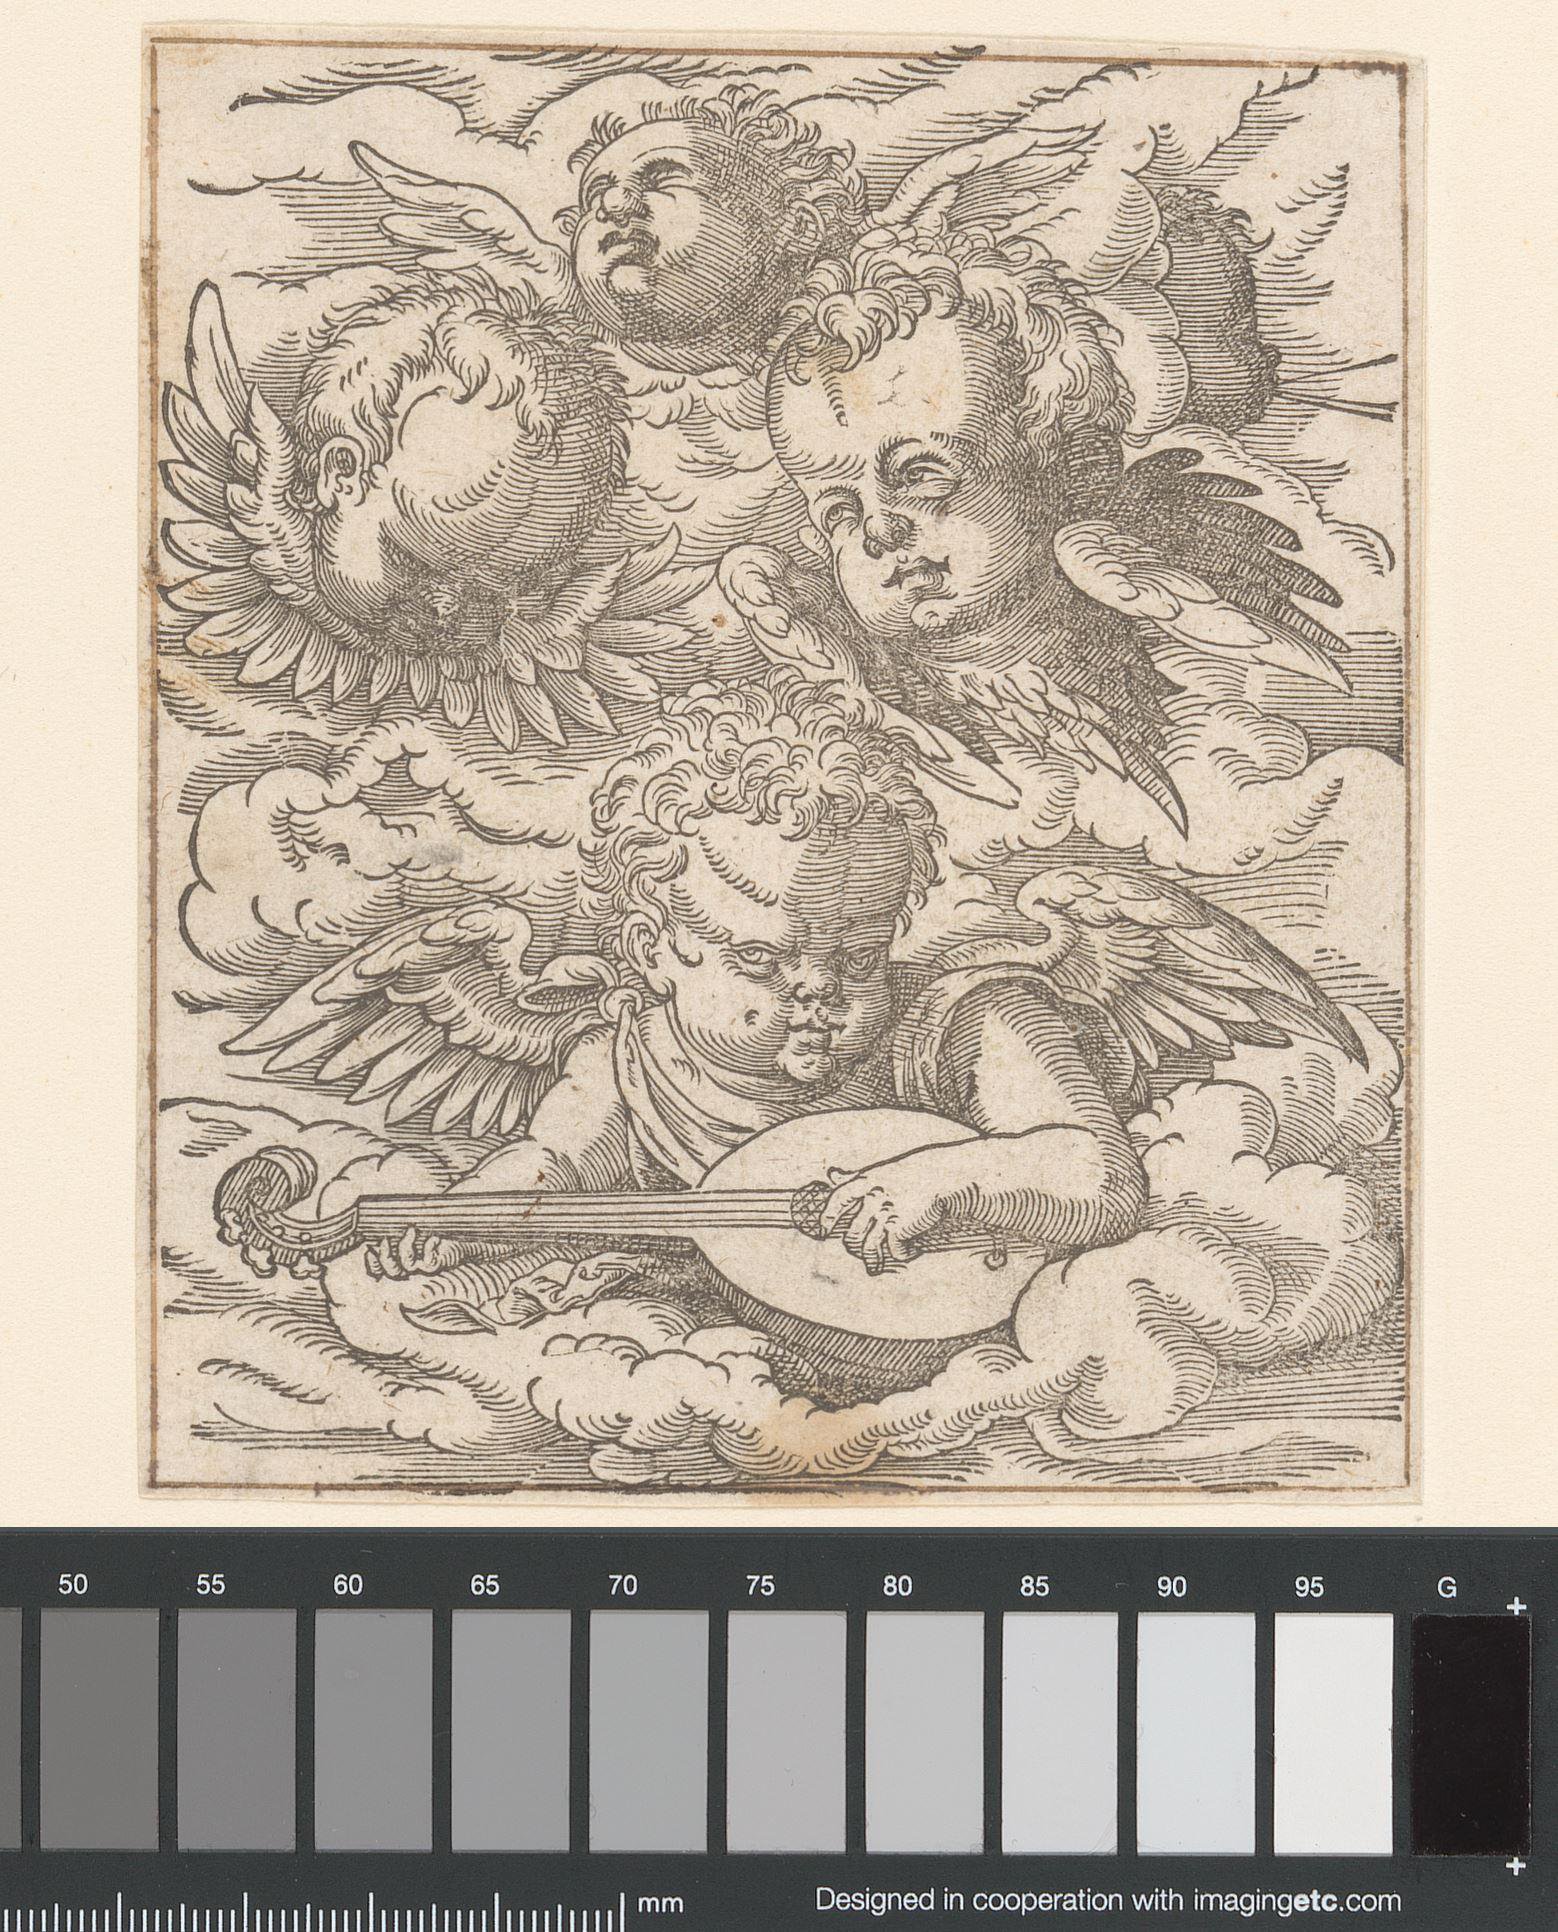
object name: print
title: Drie cherubijnen en een putto met een luit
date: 1580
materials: paper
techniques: woodcut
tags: cherubs, i.e. children's heads with wings, cupids together with attributes of the arts, sciences, etc.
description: Prent ook gebruikt in: Amman, Jost. Kunstbüchlein. Frankfurt am Main: Feyerabend, 1580.